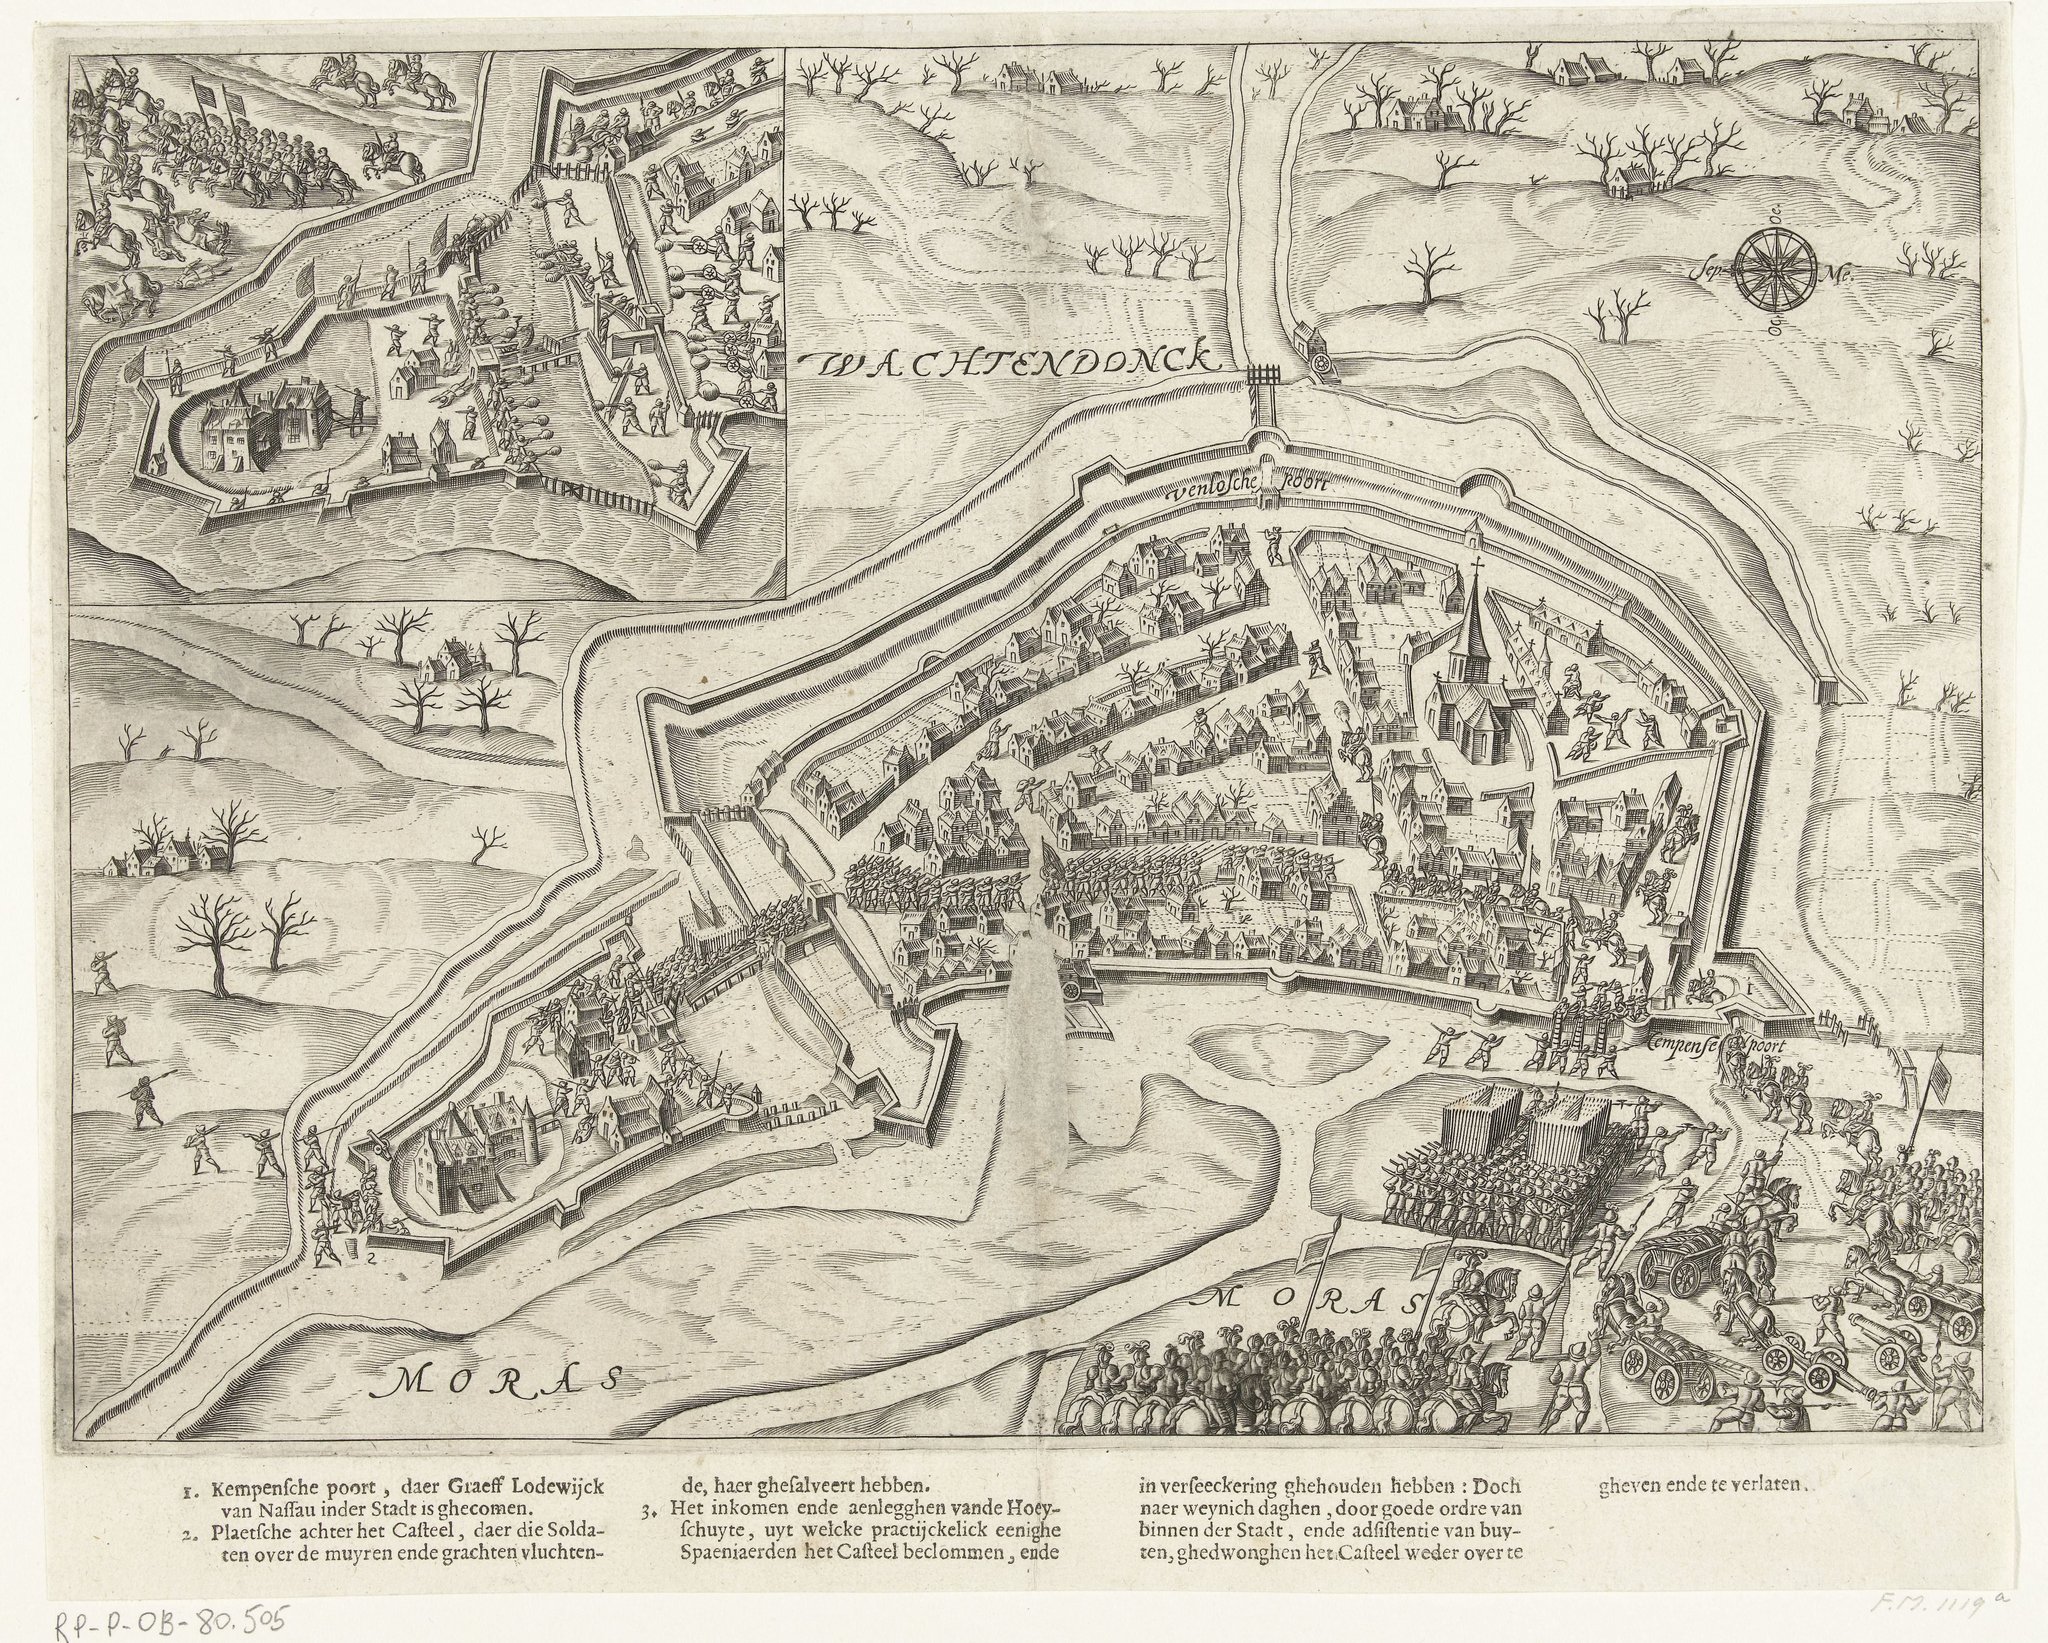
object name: print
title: Verovering van Wachtendonk, 1600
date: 1600-1601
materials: paper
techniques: engraving, letterpress printing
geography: northern netherlands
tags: capture of city (after the siege)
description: Gebruikt als illustratie in: J.J. Orlers, Den Nassauschen Lauren-Crans: Beschrijvinghe ende af-beeldinge van alle de victorien ... die Godt Almachtich de ... Staten der Vereenichde Nederlanden verleent heeft, deur het wijs ende clouck beleyt des Hooch-ghebooren Fursts Maurits van Nassau, J.J. Orlers en H. van Haestens, Leiden 1610, fol. 142/143.